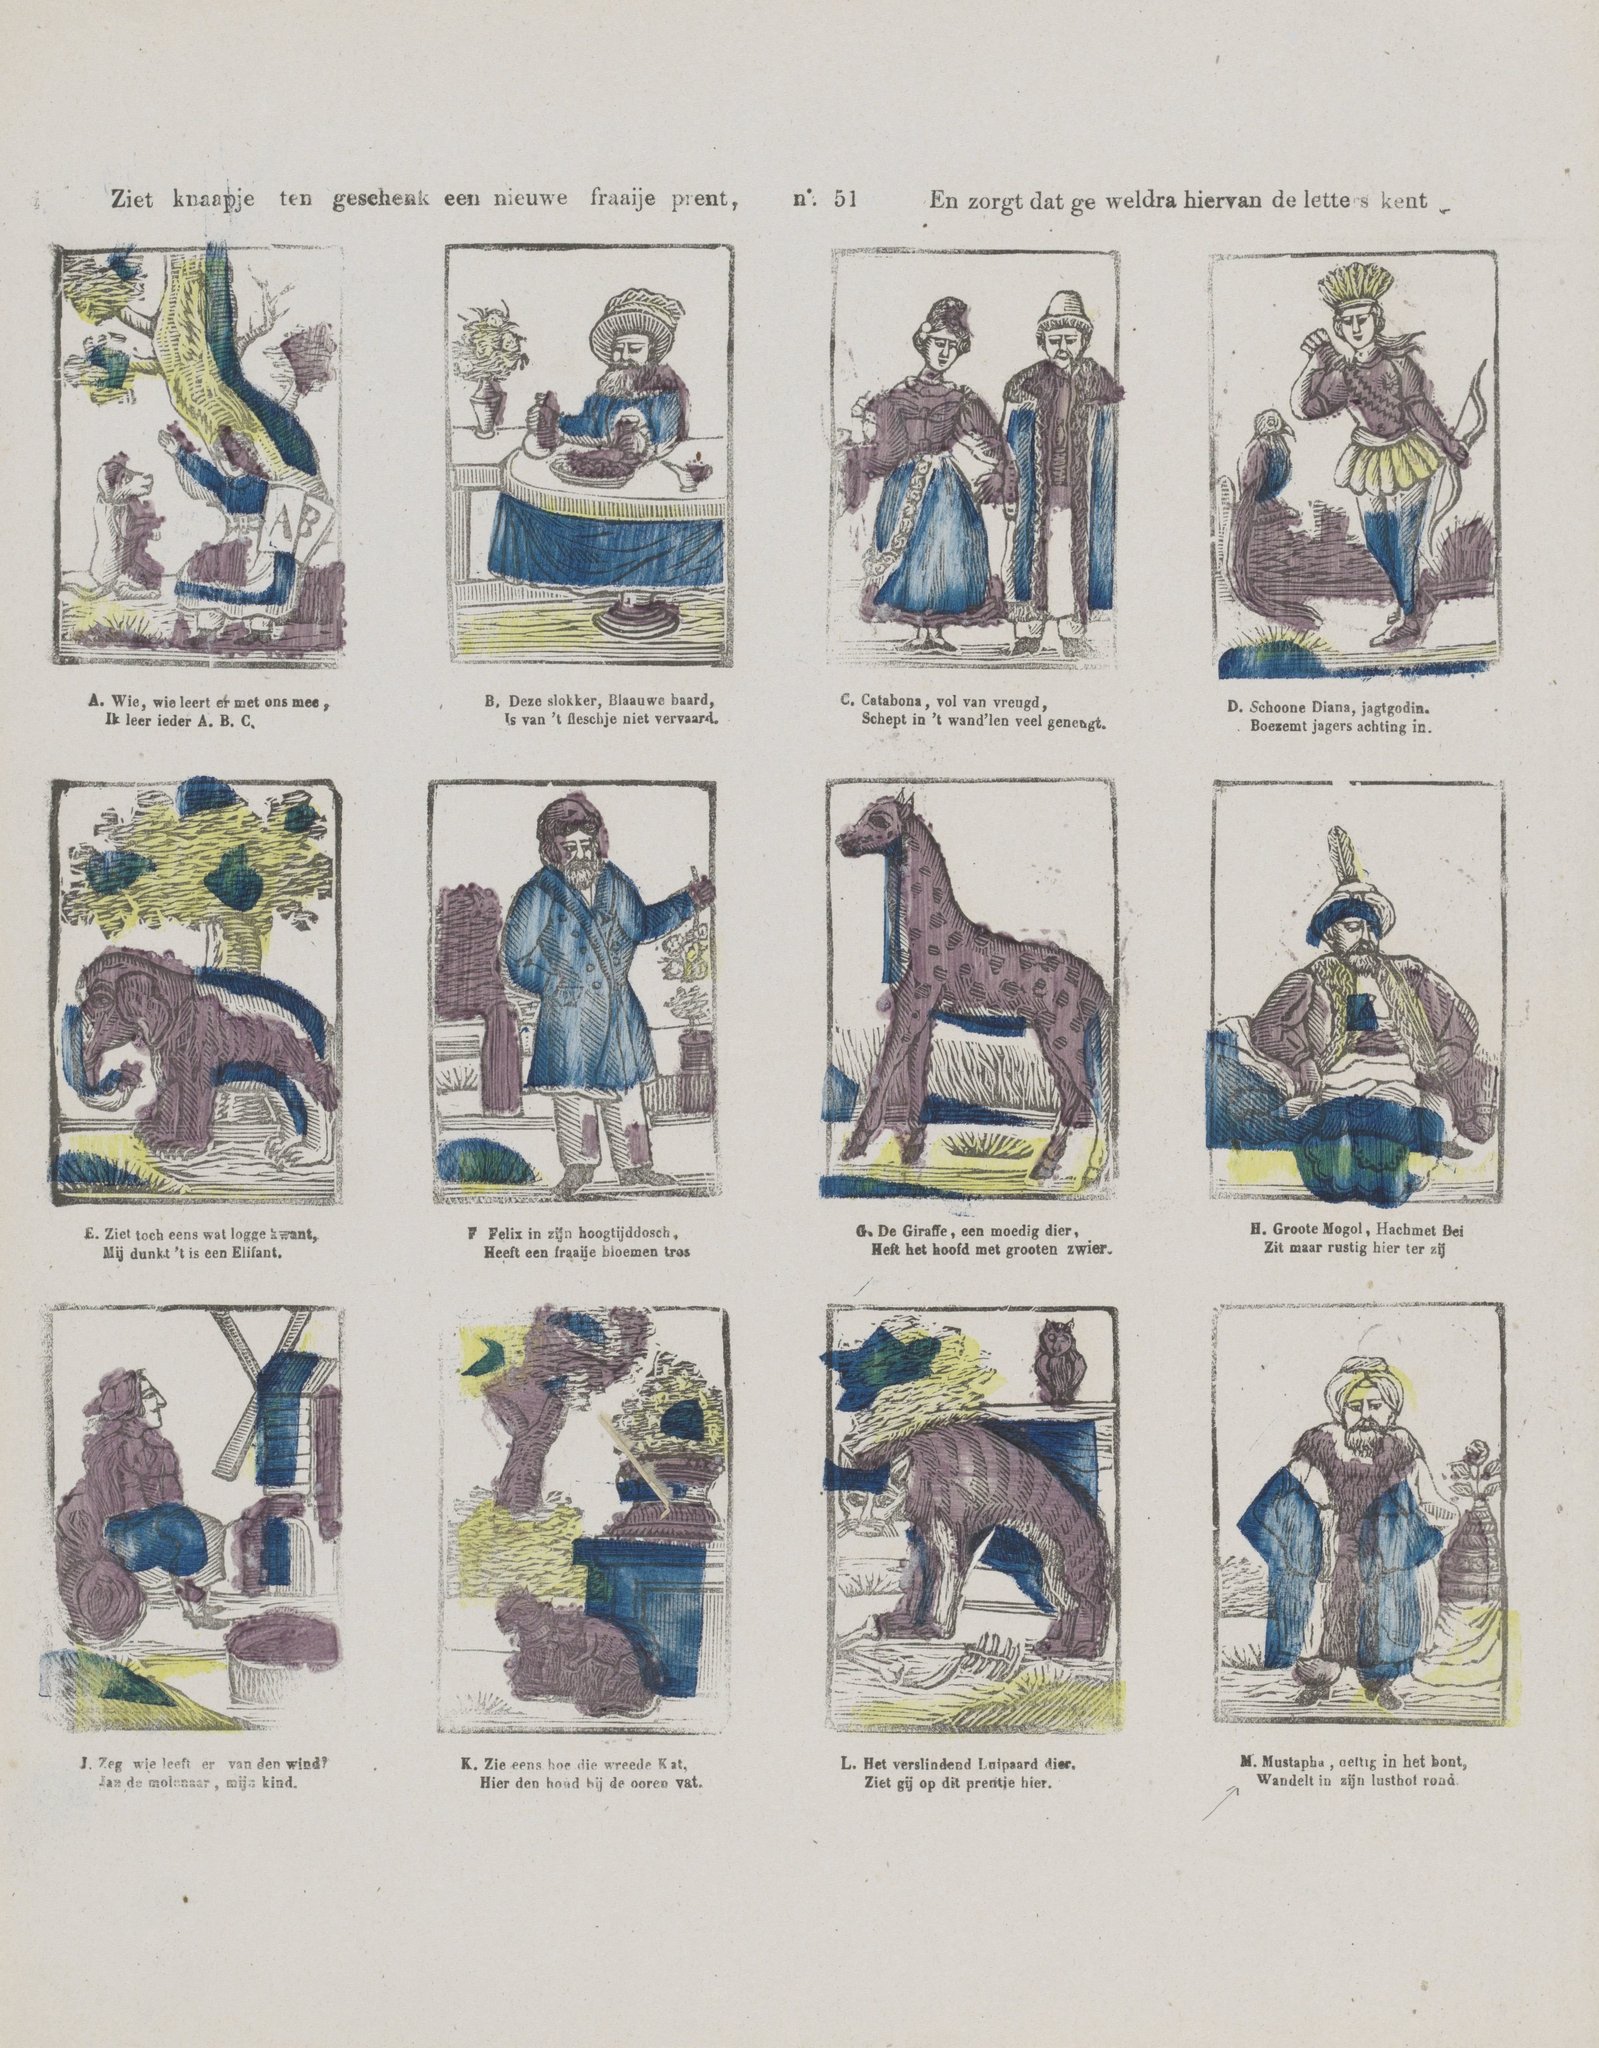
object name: popular print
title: Ziet knaapje, ten geschenk een nieuwe fraaije prent, / En zorgt dat ge weldra hiervan de letters kent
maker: Anonymous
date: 1848-1881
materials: paper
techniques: colour, letterpress printing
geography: netherlands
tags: animals, human types, letters, alphabet, script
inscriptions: collector's mark: Lugt 2760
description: Blad met 12 voorstellingen van de letters (A-M) van het alfabet geïllustreerd met figuren en dieren waarvan de woorden met de betreffende letter beginnen. Onder elke afbeelding een tweeregelig vers. Genummerd midden boven: no. 51.